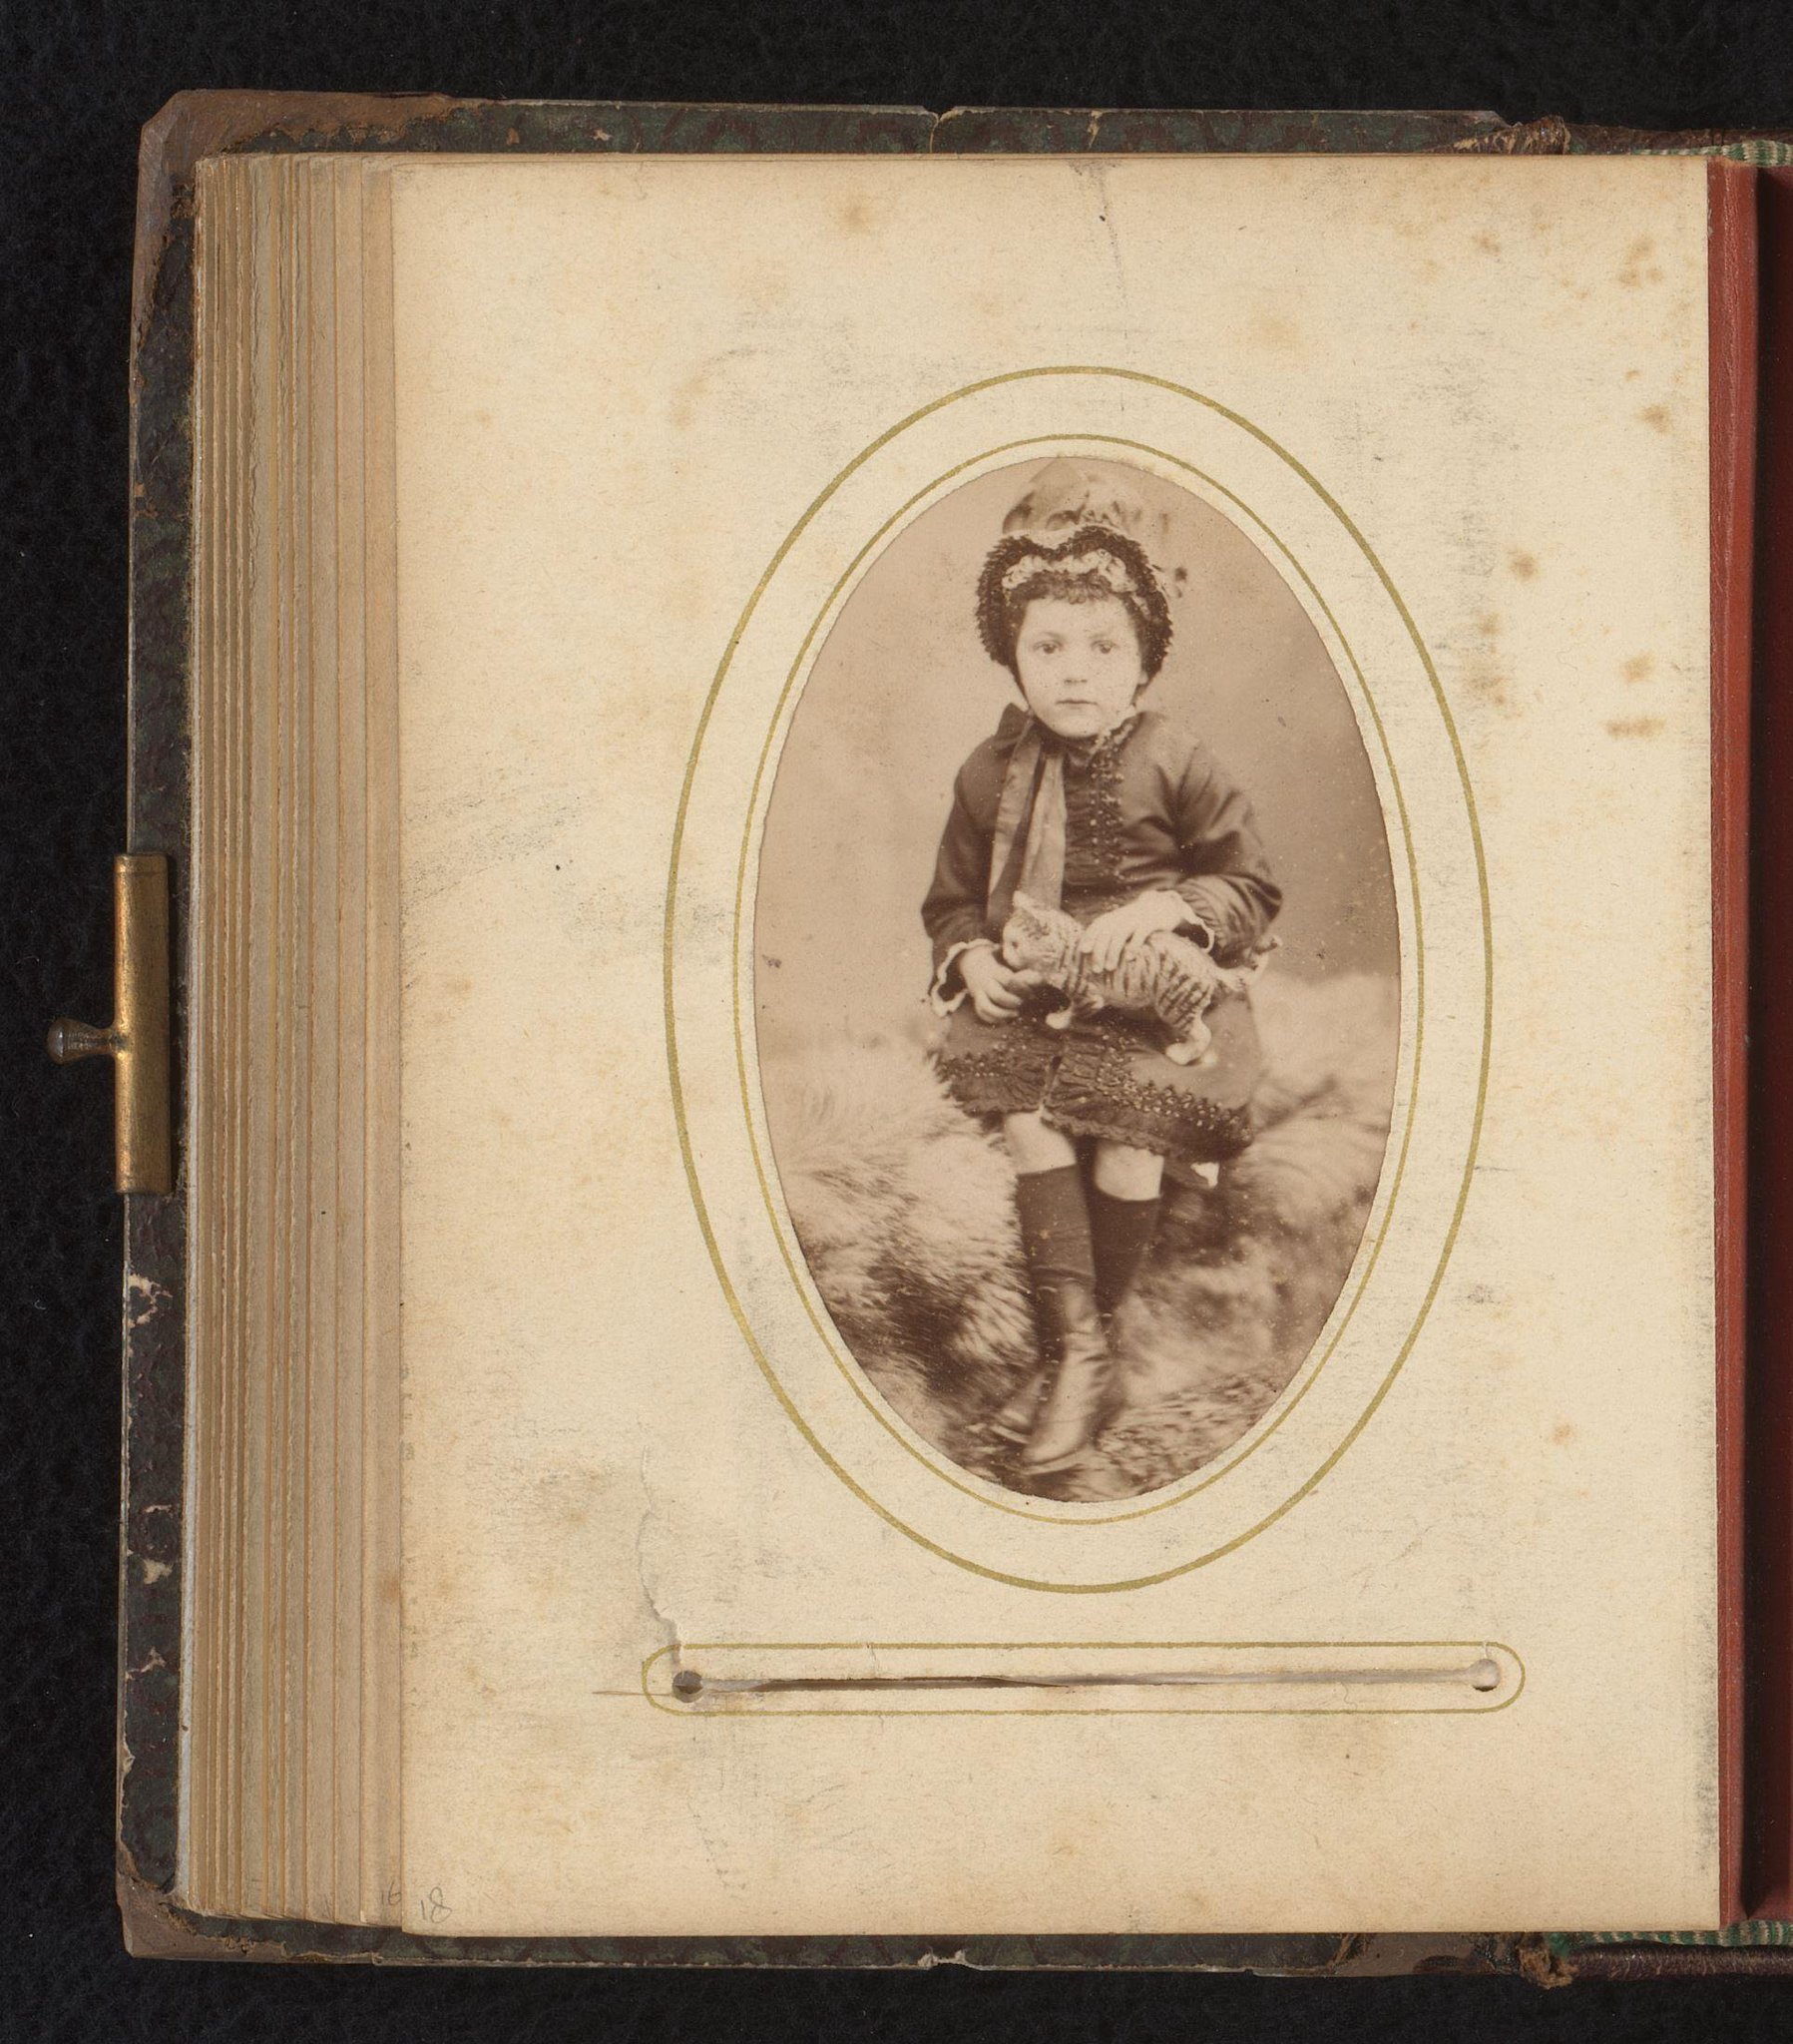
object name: album leaf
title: Portret van een meisje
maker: alfred williams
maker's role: fotograaf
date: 1870-1900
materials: cardboard, photographic support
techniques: albumen print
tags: historical persons, girl (child between toddler and youth)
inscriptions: inscription: ‘Williams/ Studio/ Broadway/ Crouch End/ London N.’